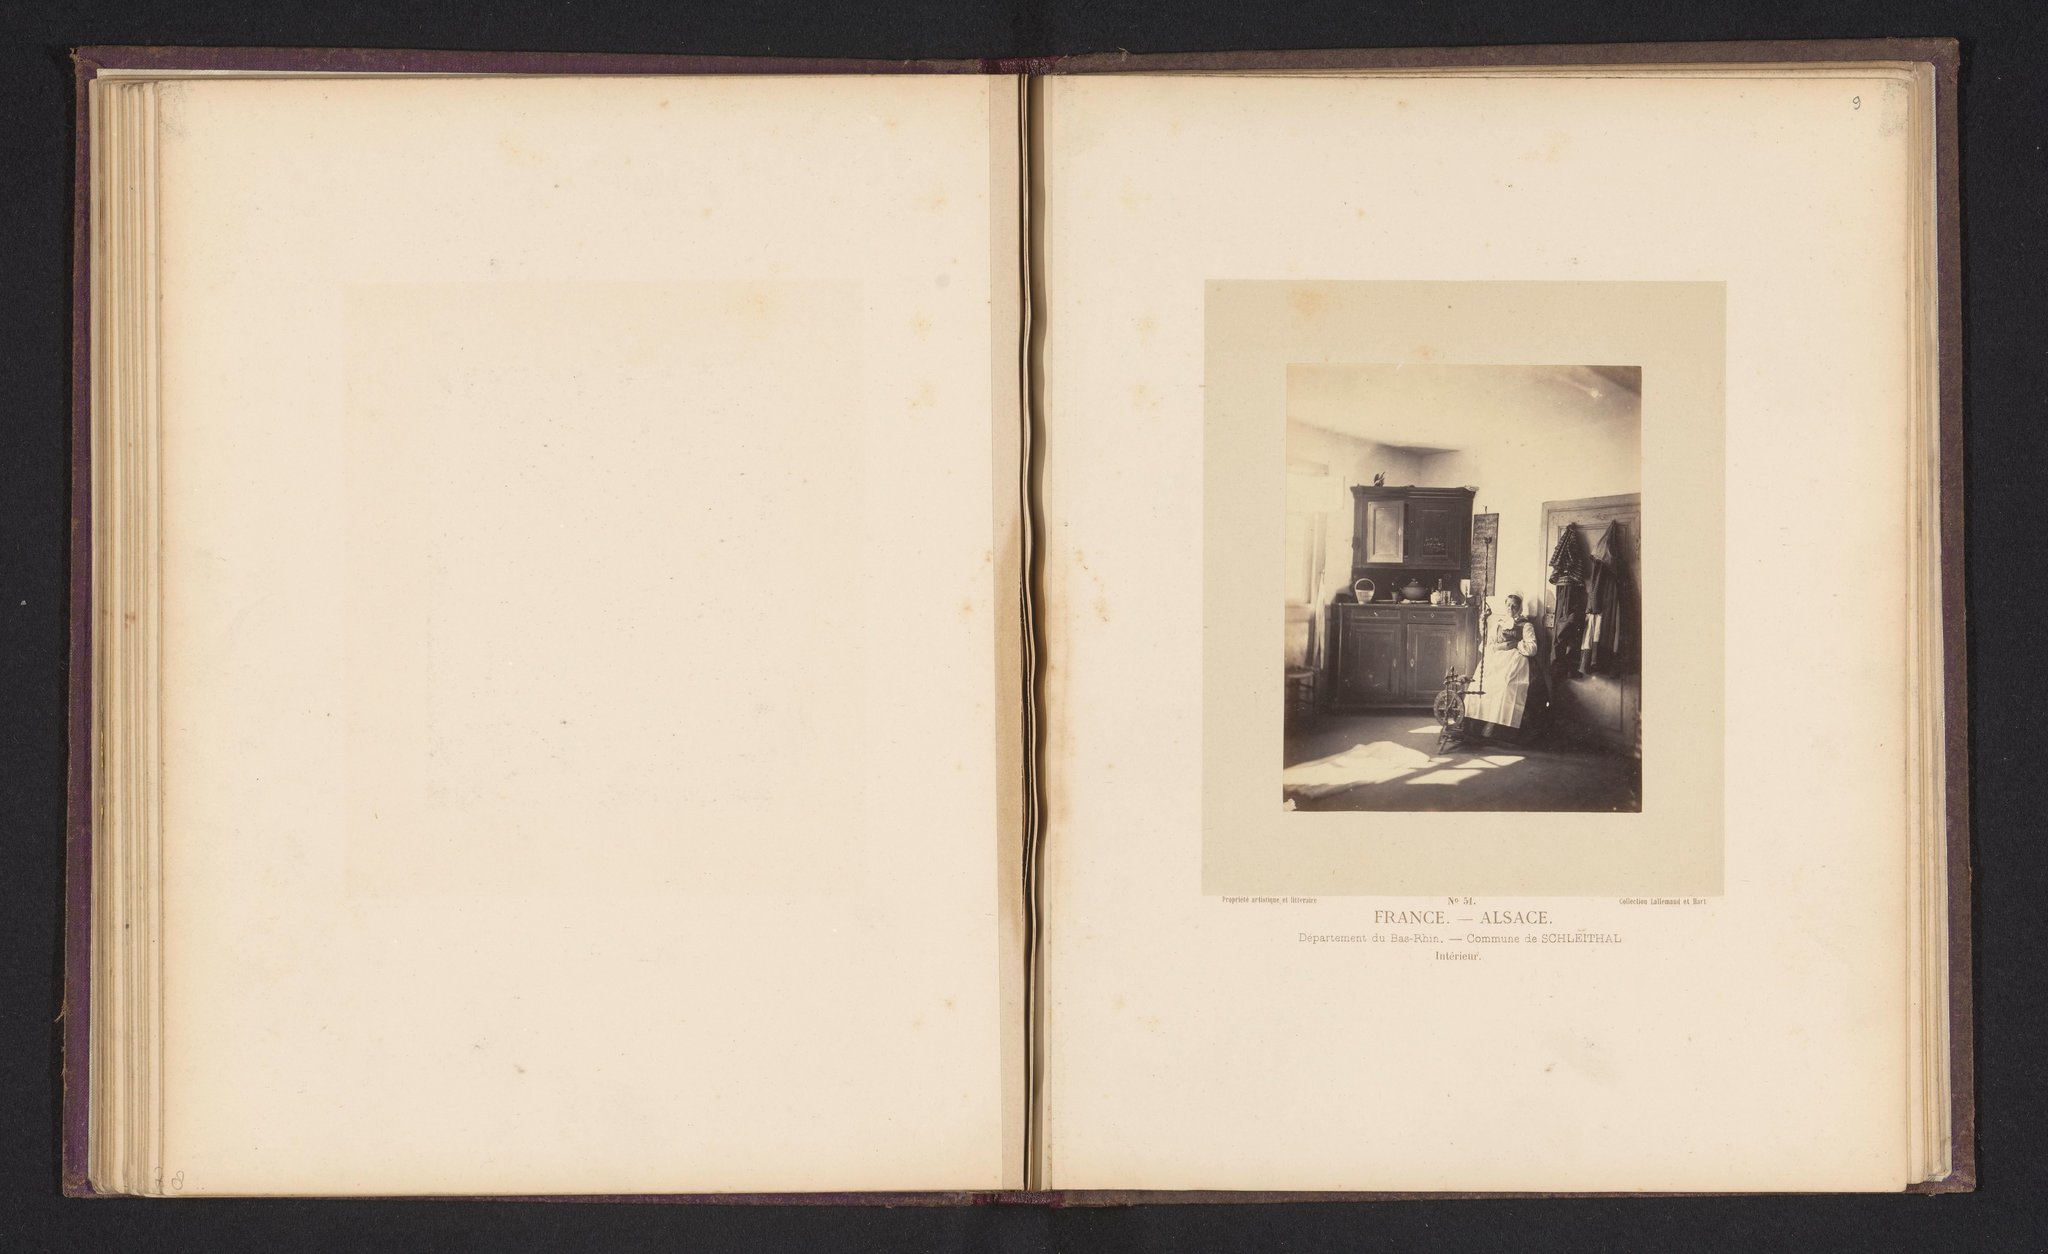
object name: photograph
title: Vrouw met een spinnewiel in een interieur te Schleithal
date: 1855-1865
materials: photographic support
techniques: albumen print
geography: schleithal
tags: spinning-wheel, interior ~ representation of a building, spinning (manufacture of yarn)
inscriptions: number: ‘No. 51.’, number: ‘9’, inscription: ‘France. Alsace. Departement du Bas-Rhin.- Commune de Schleithal’